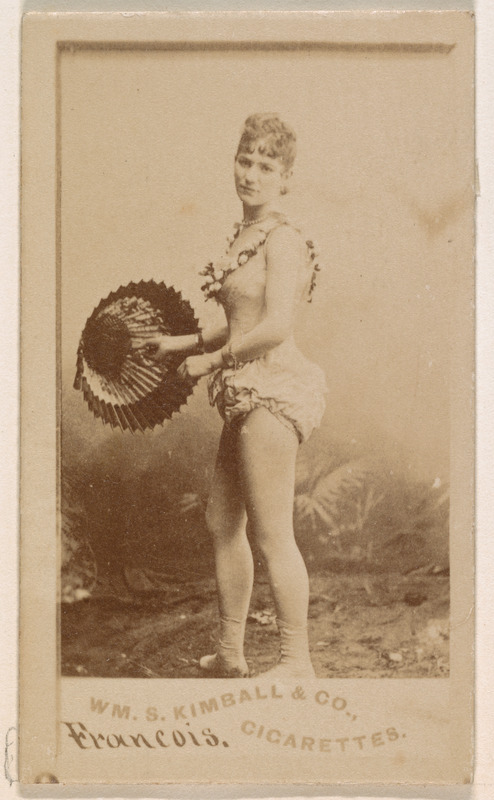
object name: photograph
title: Miss Francois, from the Actresses series (N203) issued by Wm. S. Kimball & Co.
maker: william s. kimball & company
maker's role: publisher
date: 1889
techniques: color lithograph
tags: portraits,women,actresses